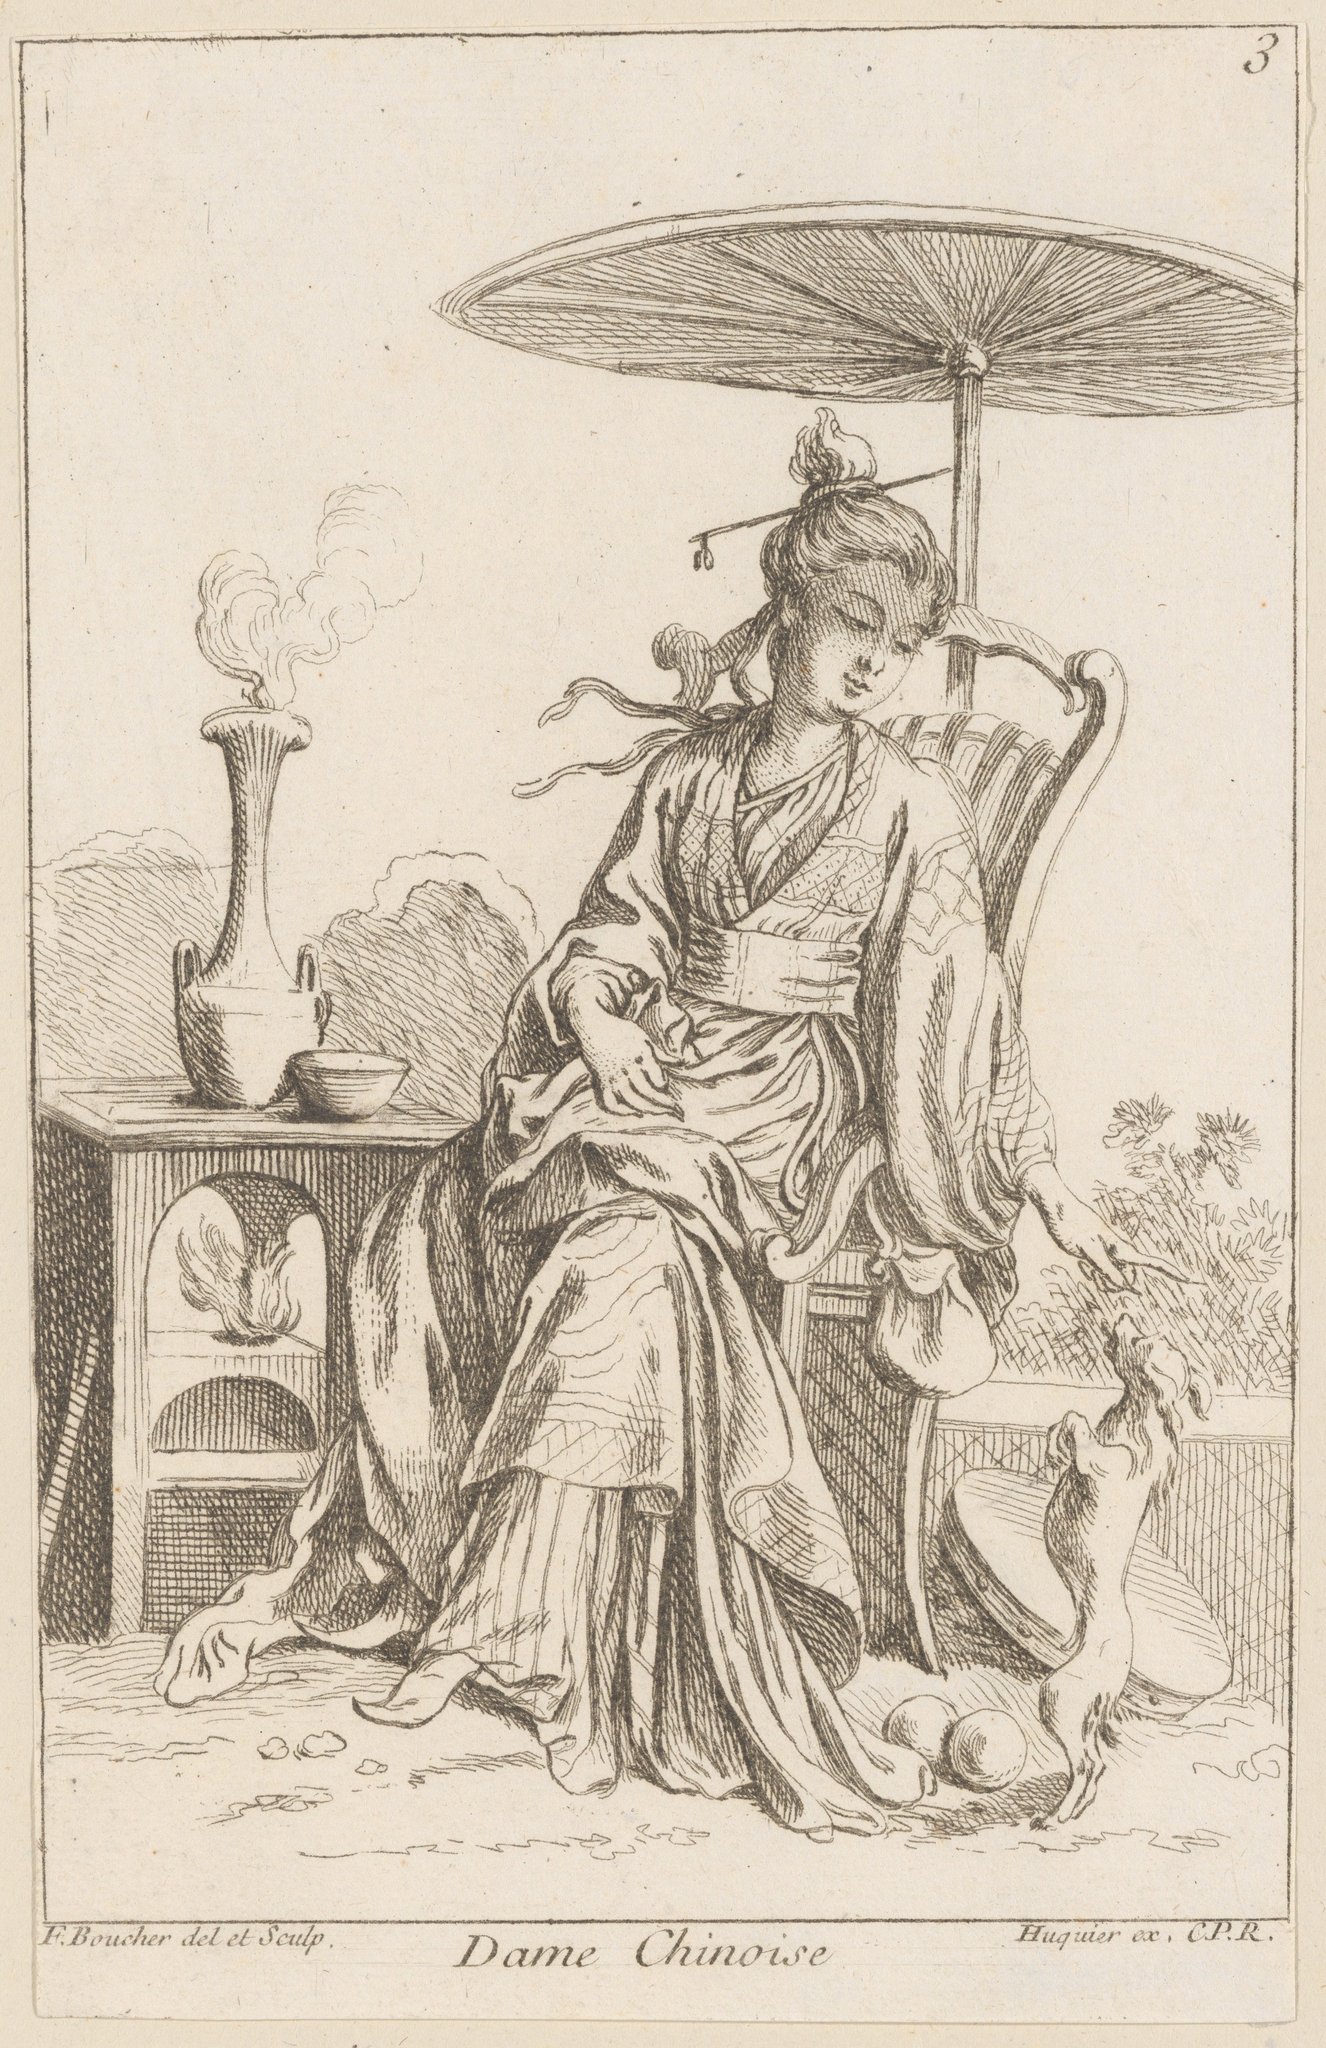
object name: print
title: Chinese Lady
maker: françois boucher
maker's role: artist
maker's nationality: french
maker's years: 1703-1770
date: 1738-1745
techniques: etching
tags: women,dogs